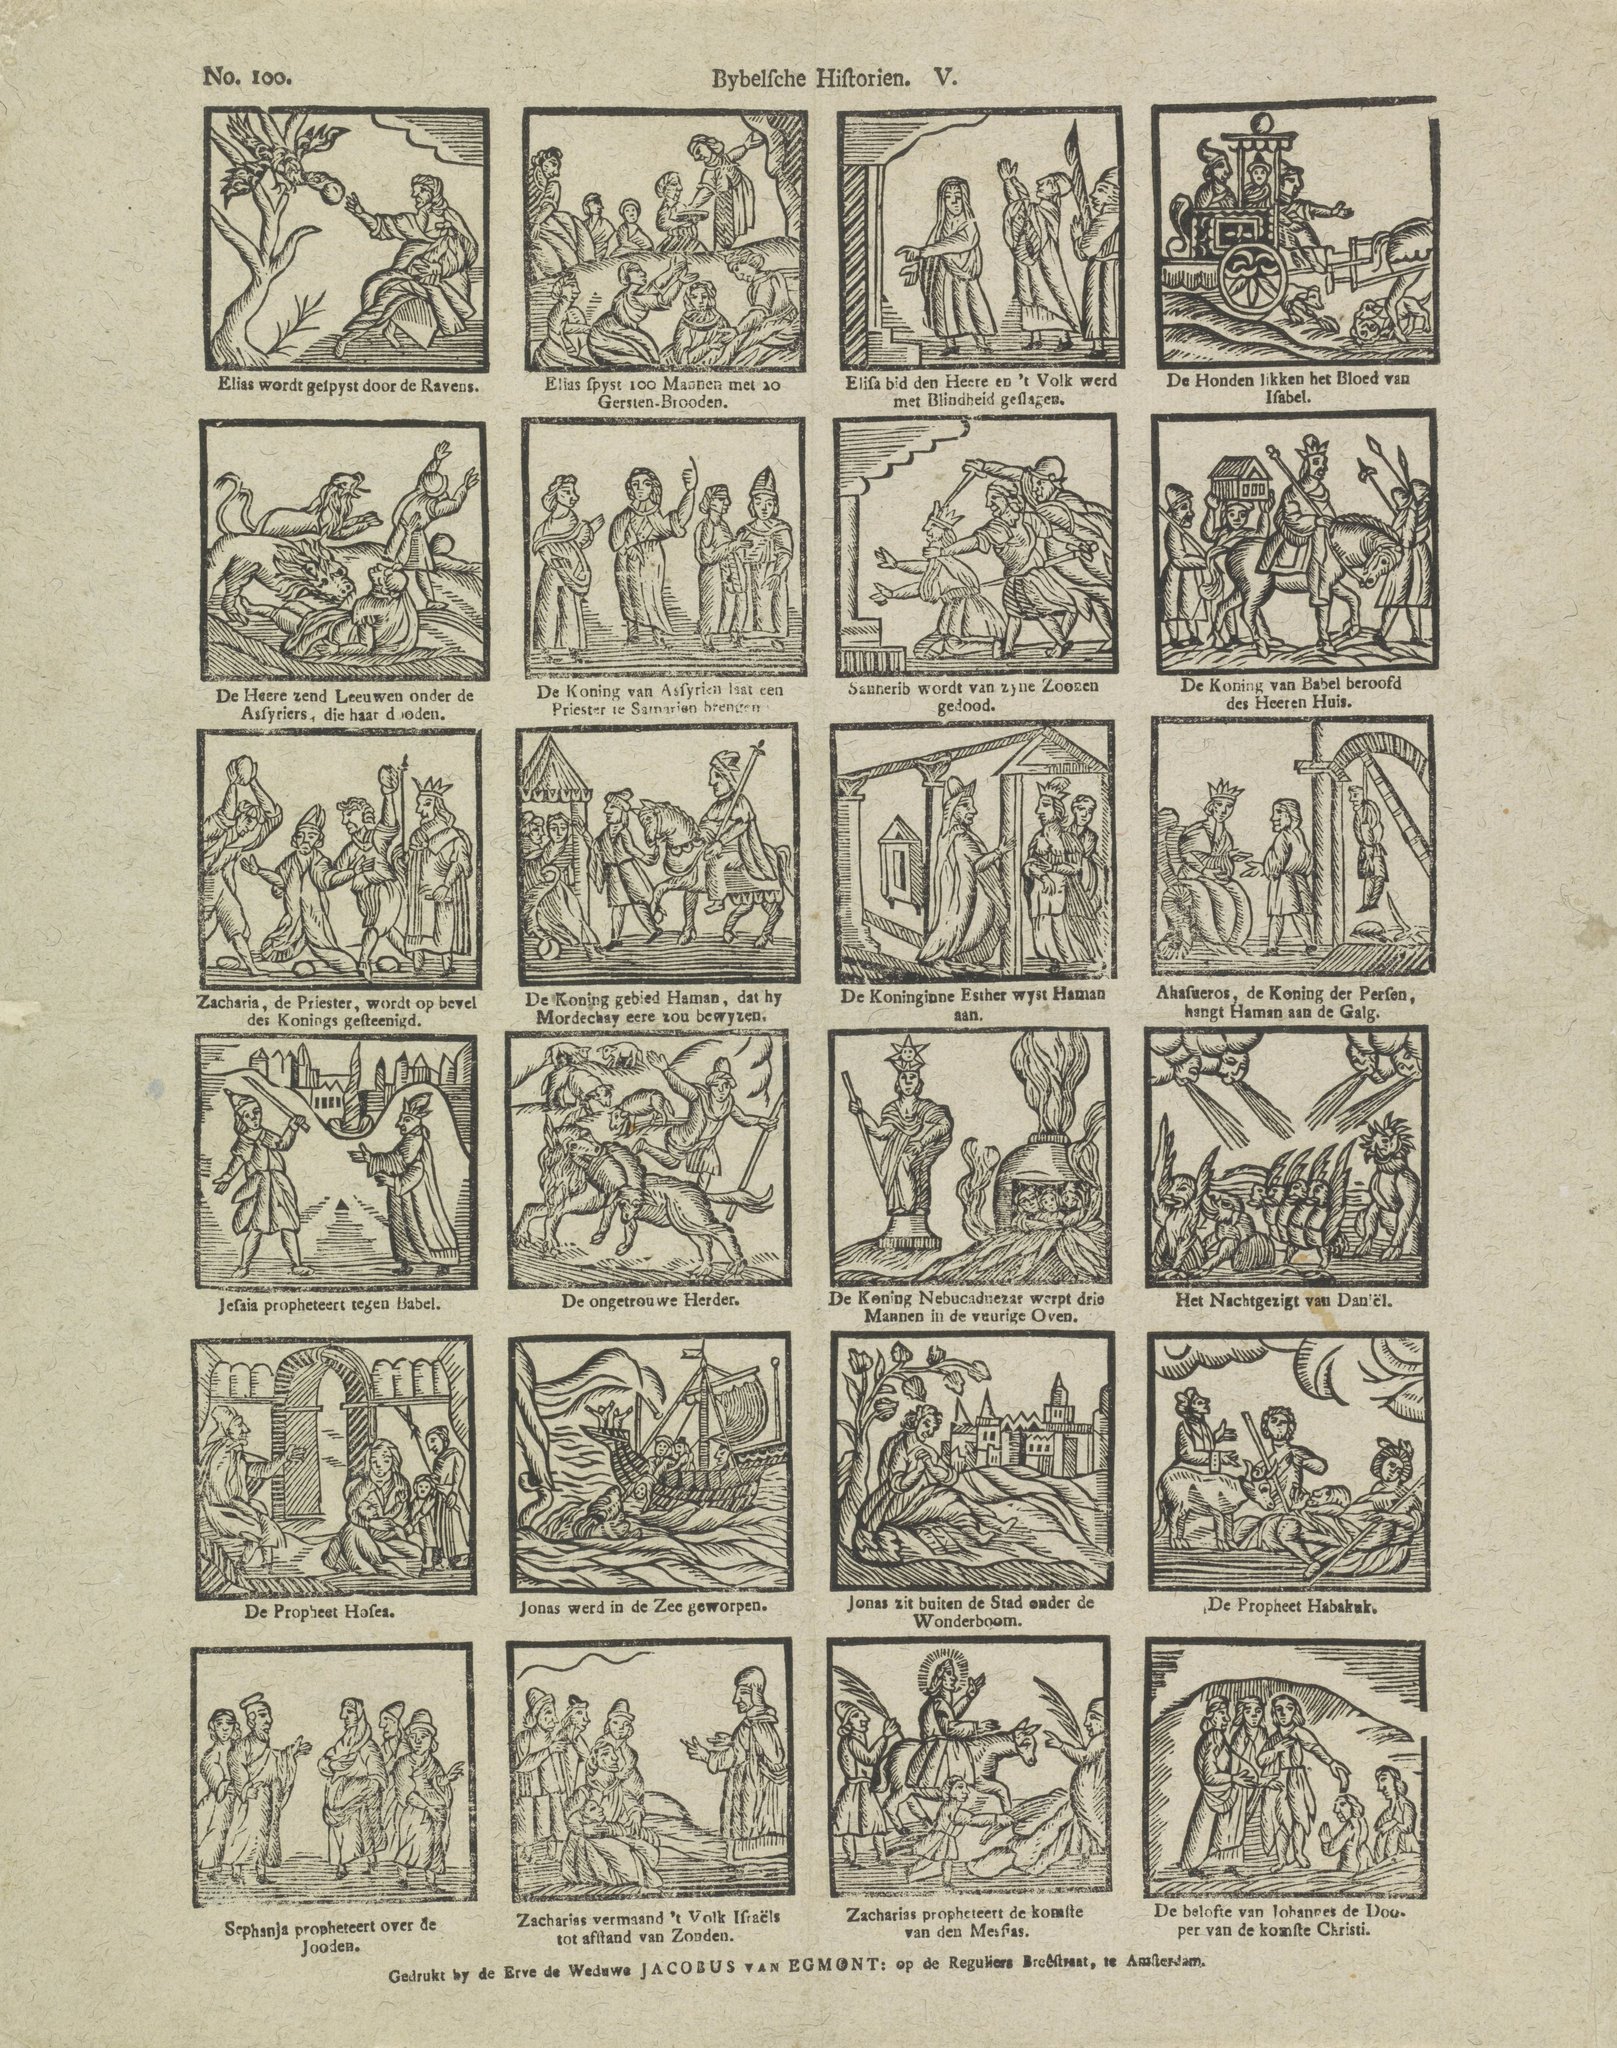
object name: print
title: Bybelsche historien. V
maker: Anonymous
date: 1761-1804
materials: paper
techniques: letterpress printing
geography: amsterdam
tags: old testament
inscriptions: collector's mark: Lugt 2760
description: Blad met 24 voorstellingen van verhalen uit het Oude Testament, waaronder de ontrouwe herder, drie jongelingen in de brandende vuuroven en de belofte van Johannes de Doper van de komst van Christus. Onder elke afbeelding een onderschrift. Genummerd linksboven: No. 100.